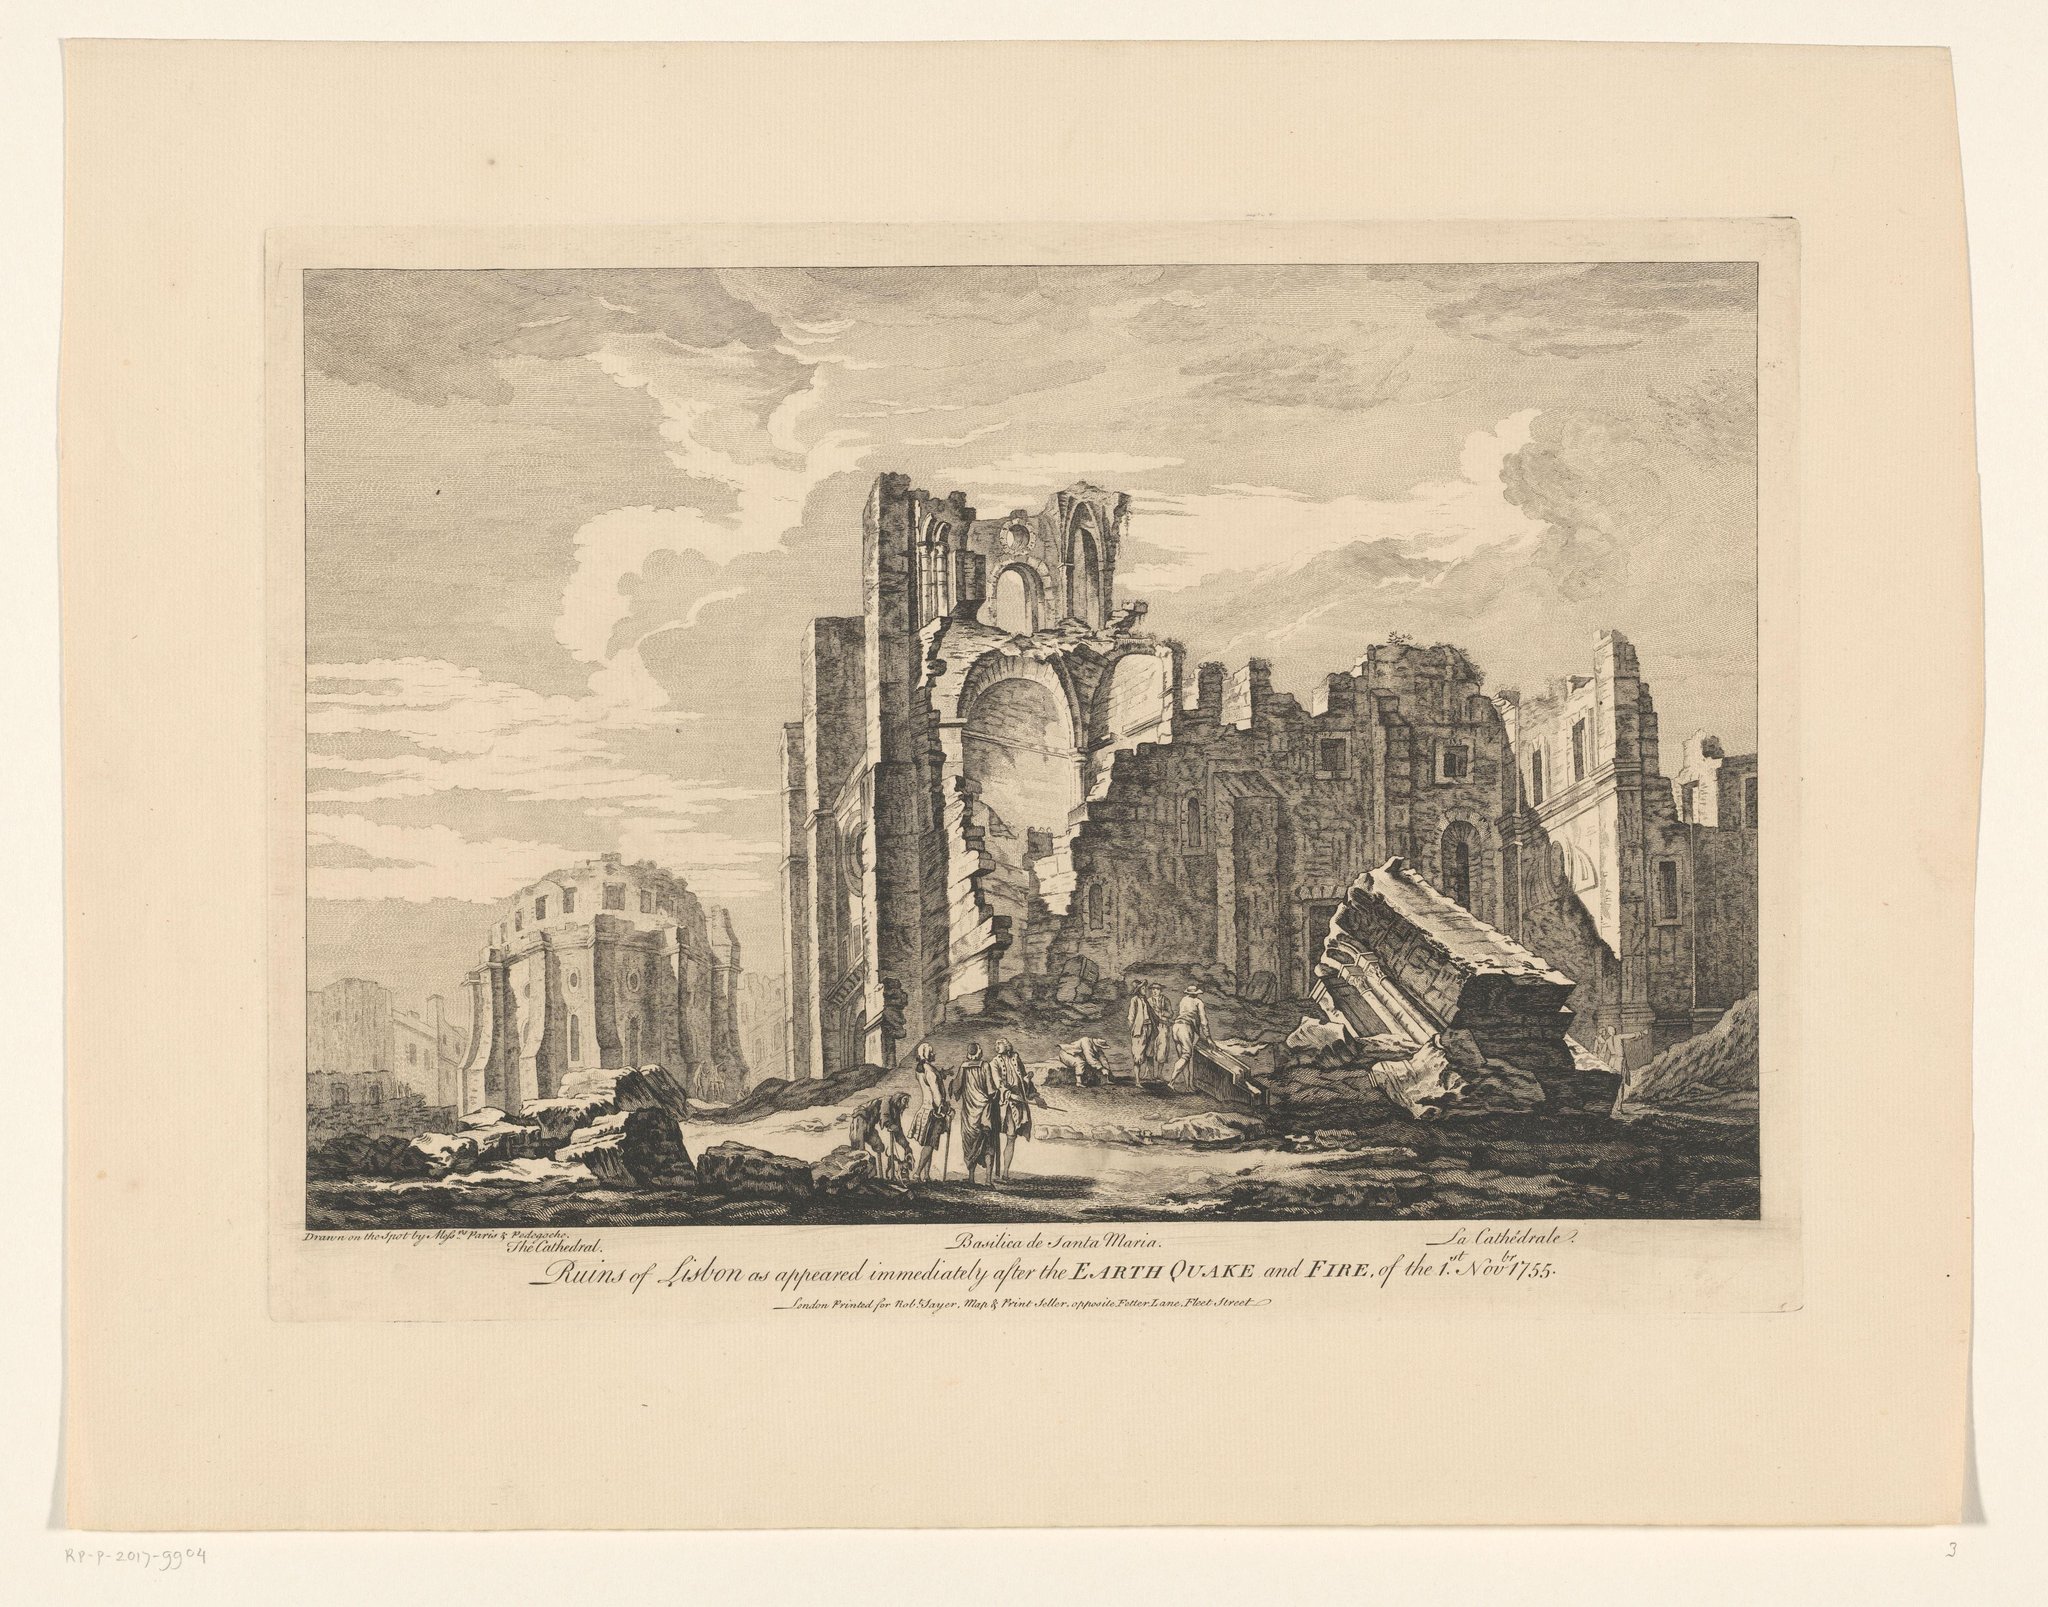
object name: print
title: Ruins of Lisbon as appeared immediately after the Earthquake and Fire of the 1st Novbr 1755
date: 1758-1760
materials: paper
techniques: etching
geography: england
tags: ruin of a building ~ architecture, consequences of an earthquake, ruin of church, monastery, etc.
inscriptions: collector's mark: Lugt 2228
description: Ruïne van de kathedraal van Lissabon. Onderdeel van een serie van zes prenten van de ruïnes van de stad Lissabon na de grote aardbeving van 1 november 1755. Kopieën naar de oorspronkelijke prentserie door J.P. Le Bas van 1758, naar tekeningen van lokale kunstenaars, waarschijnlijk amateurs, aangeduid als Paris & Pedegoche.